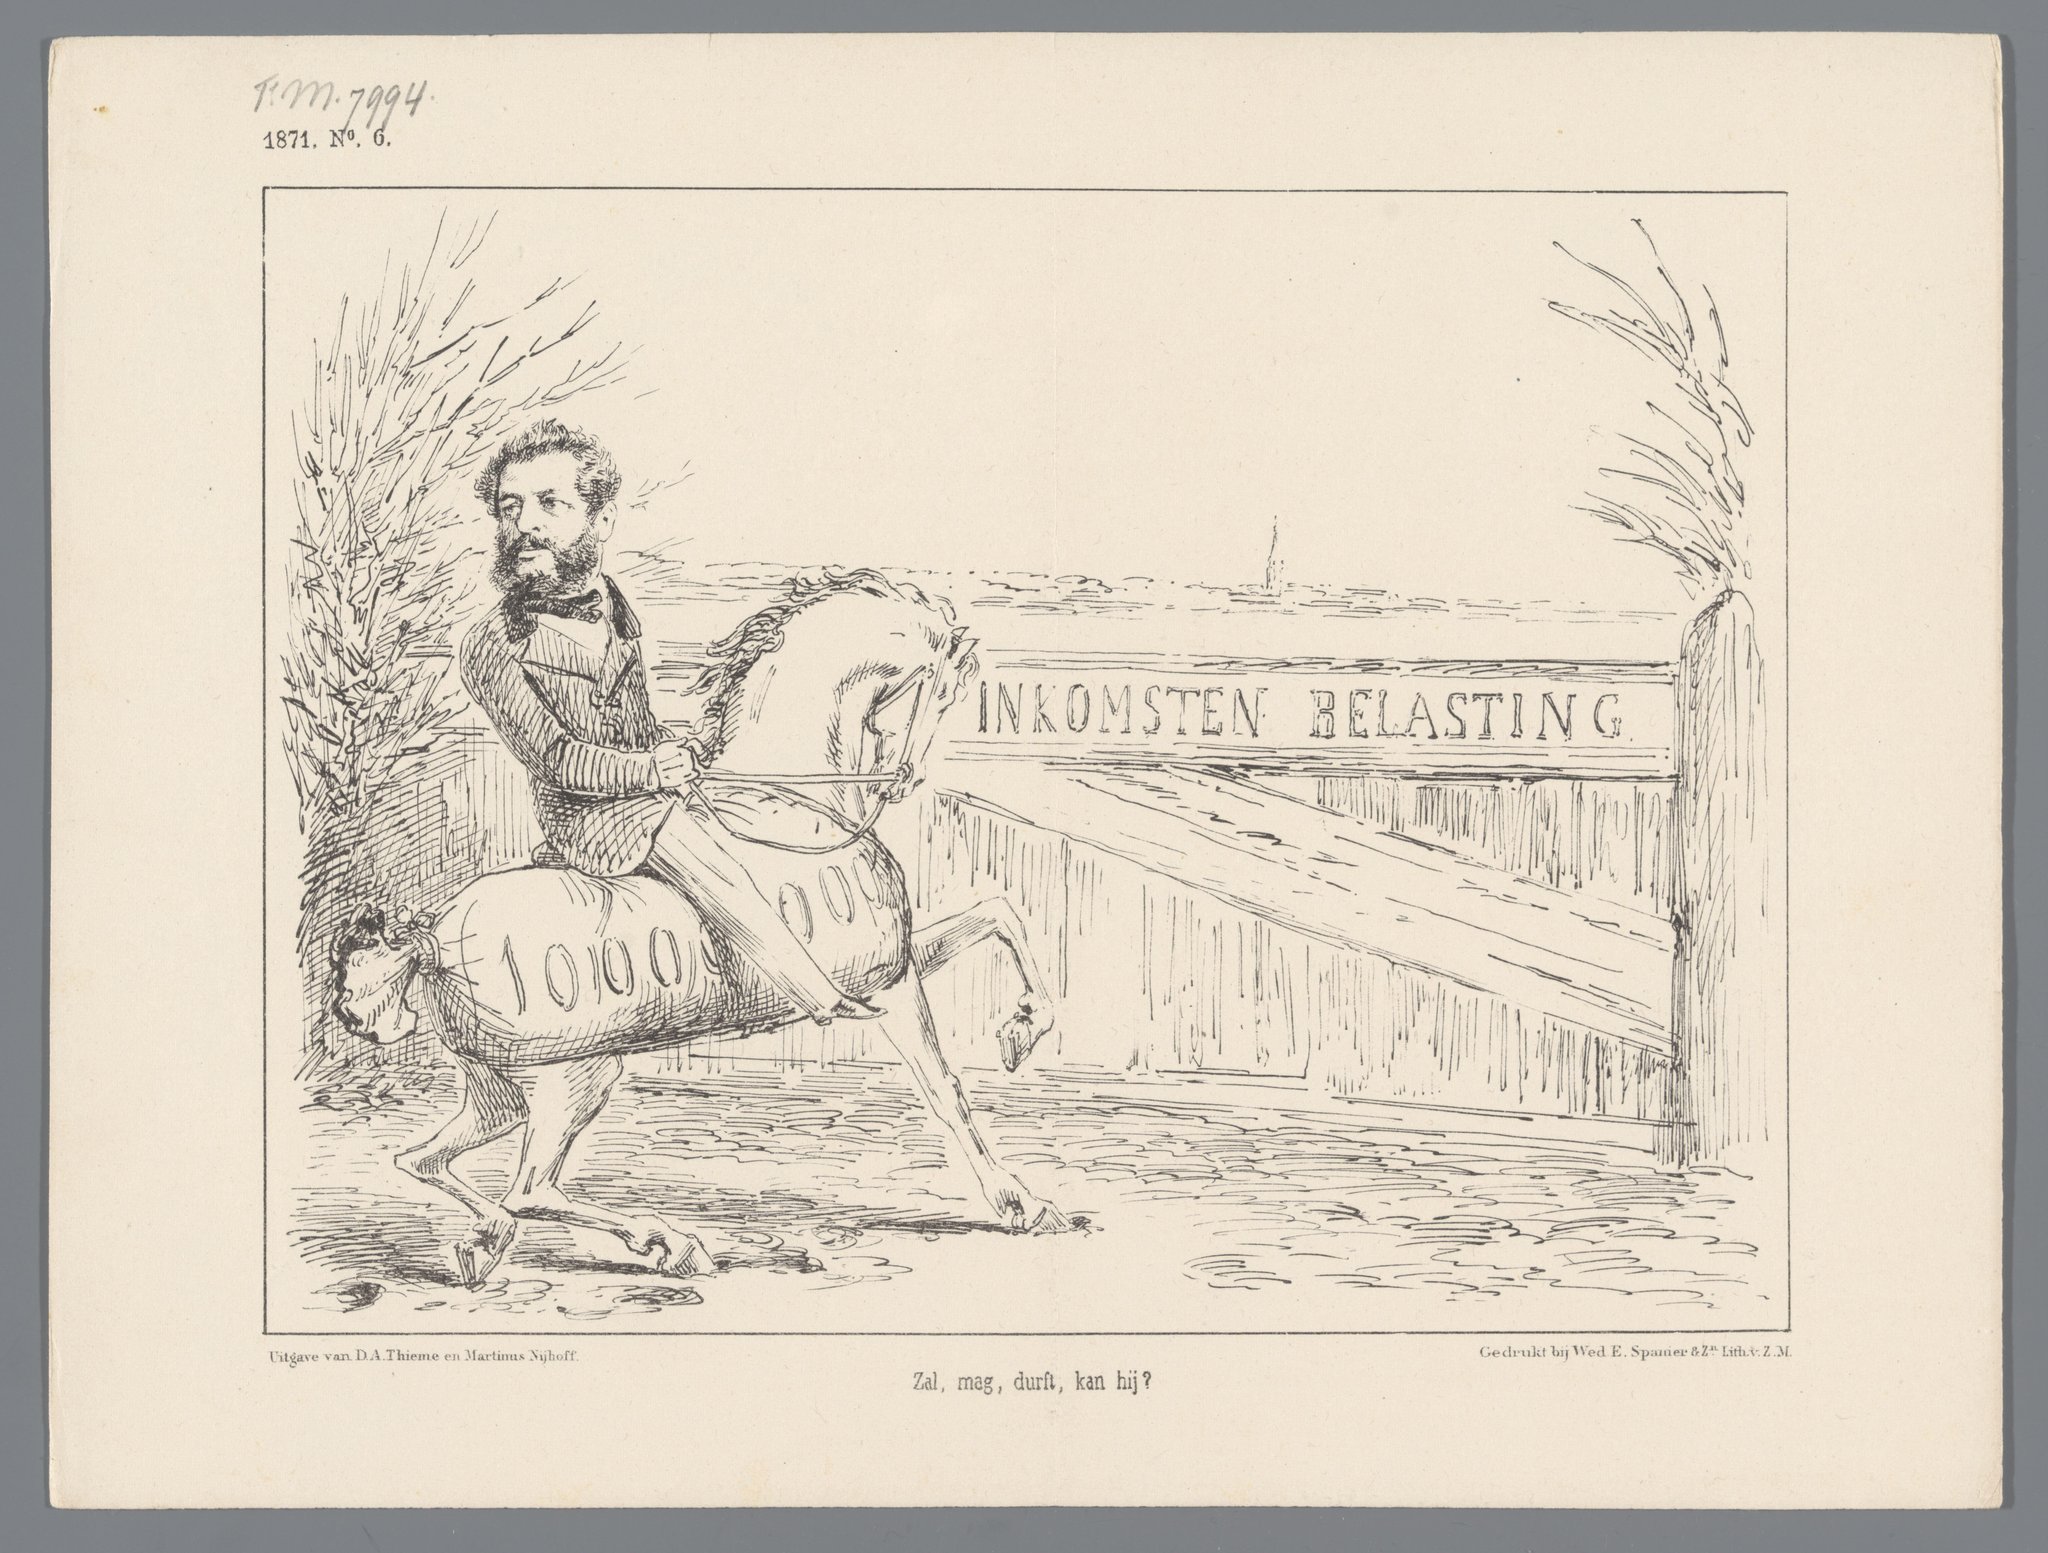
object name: print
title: Spotprent met Minister van Financiën Blussé, 1871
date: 1871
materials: paper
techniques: lithograph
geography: netherlands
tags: pieter blussé van oud-alblas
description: Spotprent met Minister van Financiën Blussé als springruiter weifeld bij de hoge barricade van de inkomstenbelasting. Plaat verschenen bij het weekblad De Nederlandsche Spectator, nr. 6, 1871.